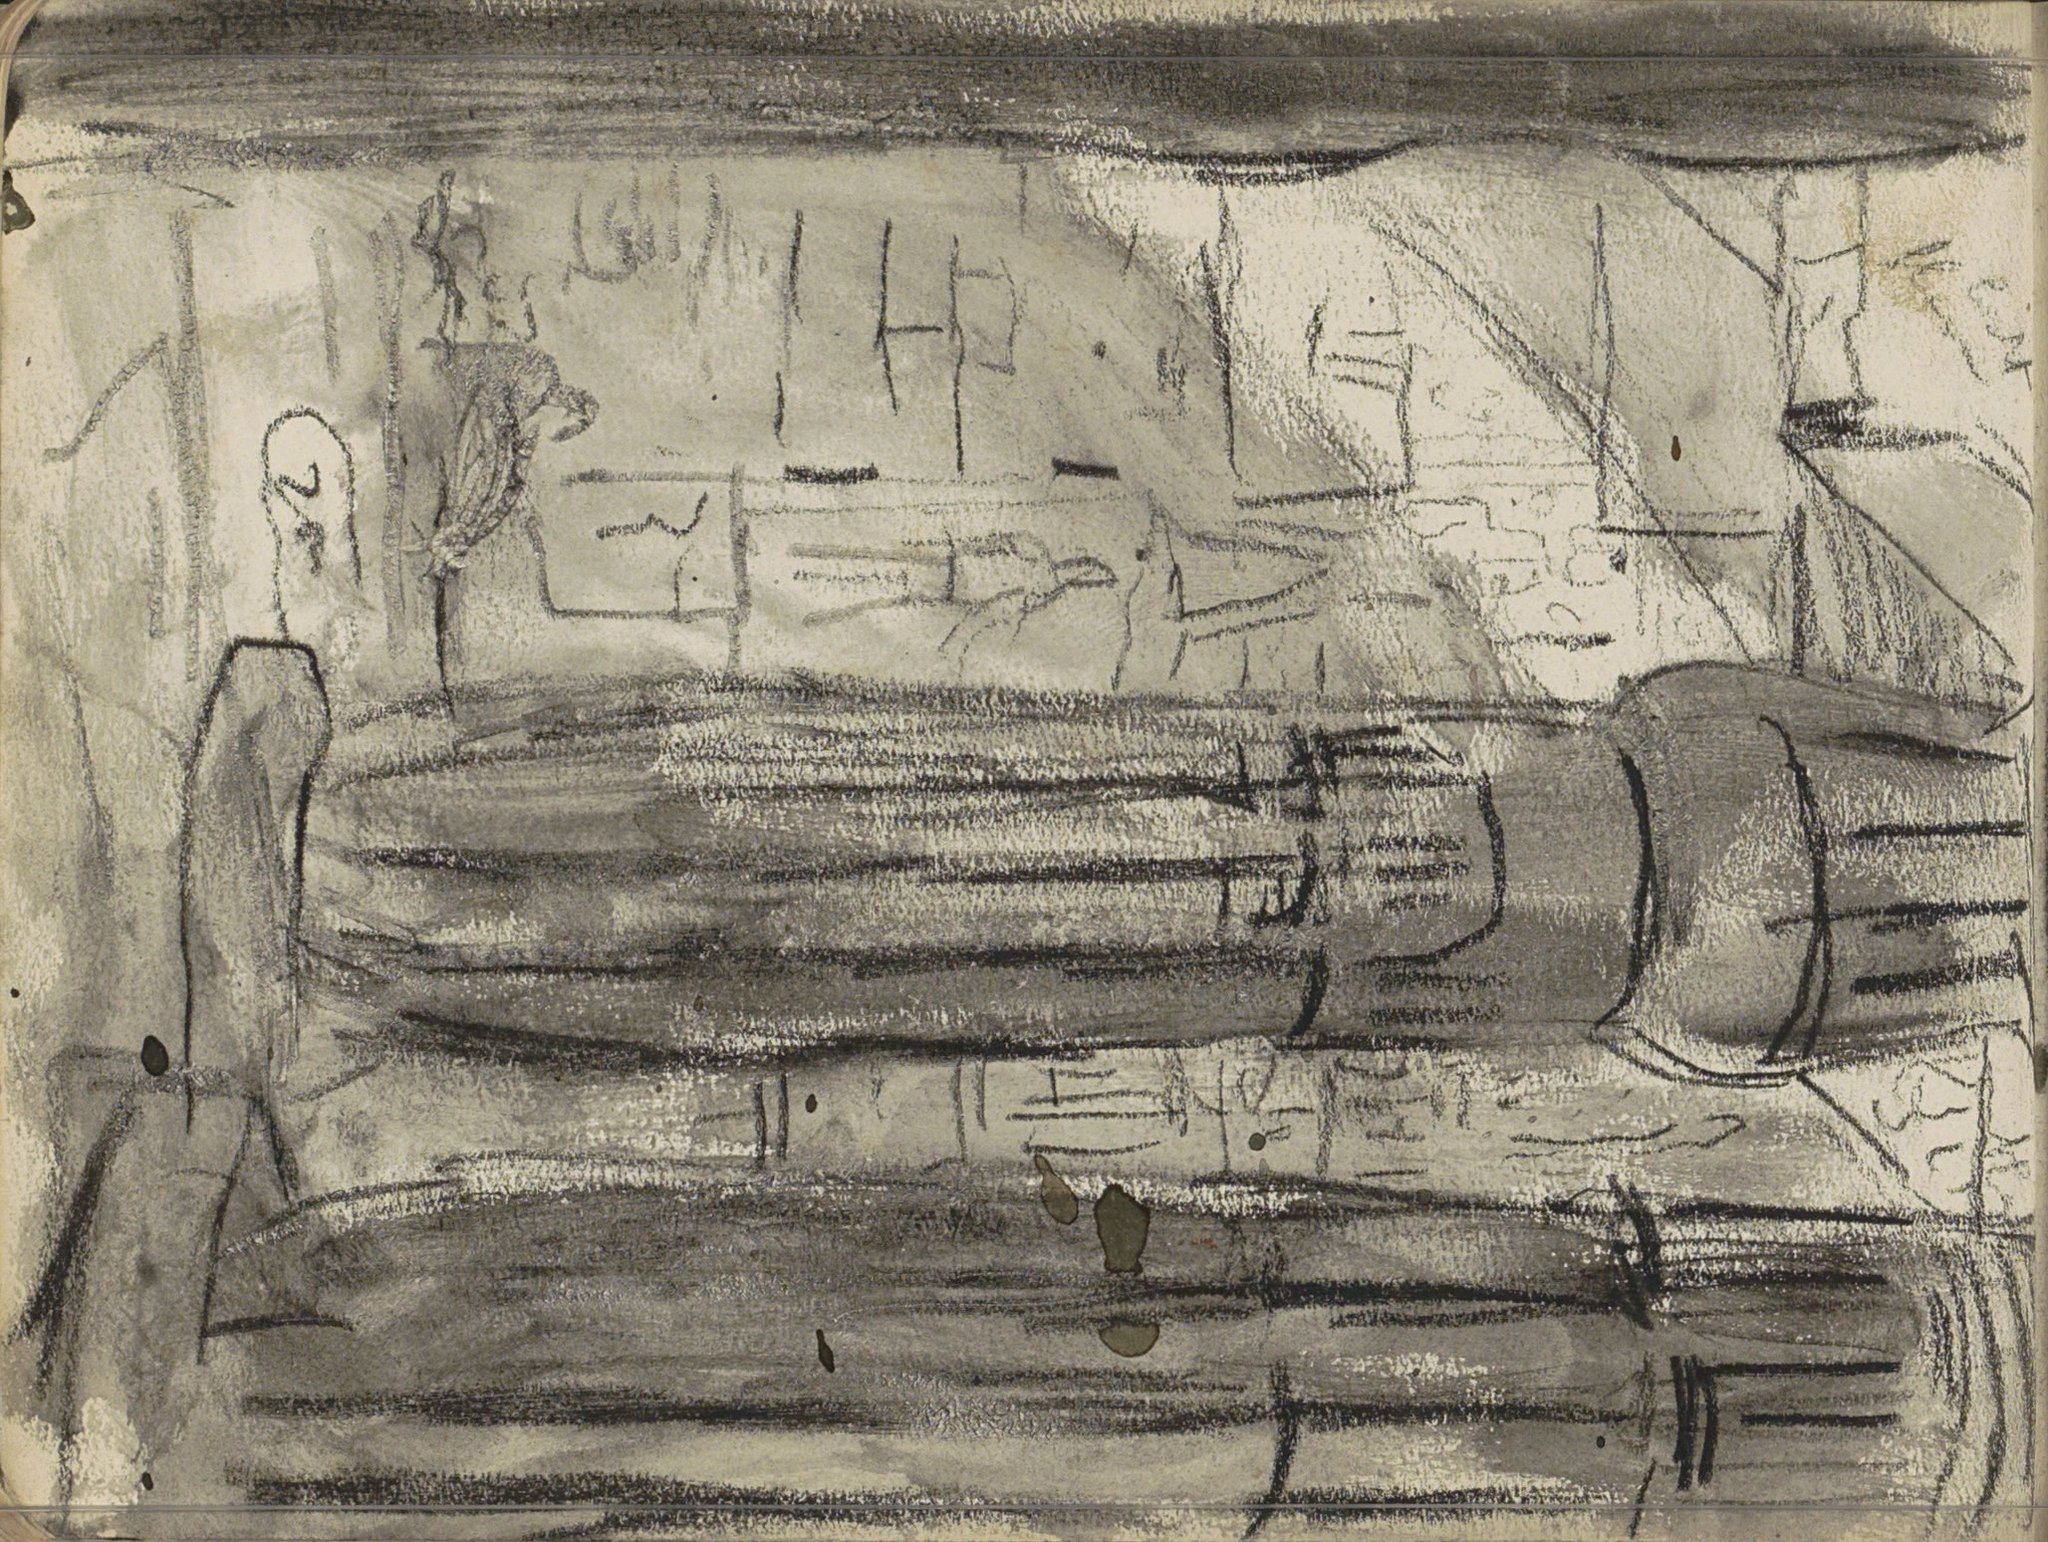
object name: sketchbook leaf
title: Interieur van de Luxortempel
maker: marius bauer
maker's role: draughtsman, print maker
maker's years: 1867-1932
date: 1919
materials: chalk, paper, watercolor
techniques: brush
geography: luxor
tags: temple, shrine ~ egyptian religion, sitting figure, art (+ relief ~ sculpture)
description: Op de wanden van de tempel zijn voorstellingen afgebeeld. Bij de wand zit een figuur. Pagina 43 uit een schetsboek met 28 bladen.